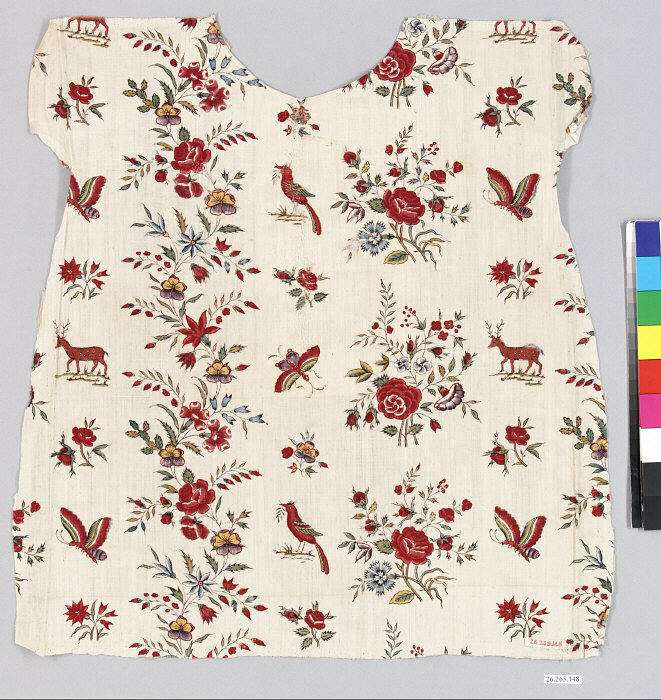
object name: piece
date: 1767-1800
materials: cotton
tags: birds,butterflies,flowers,leaves